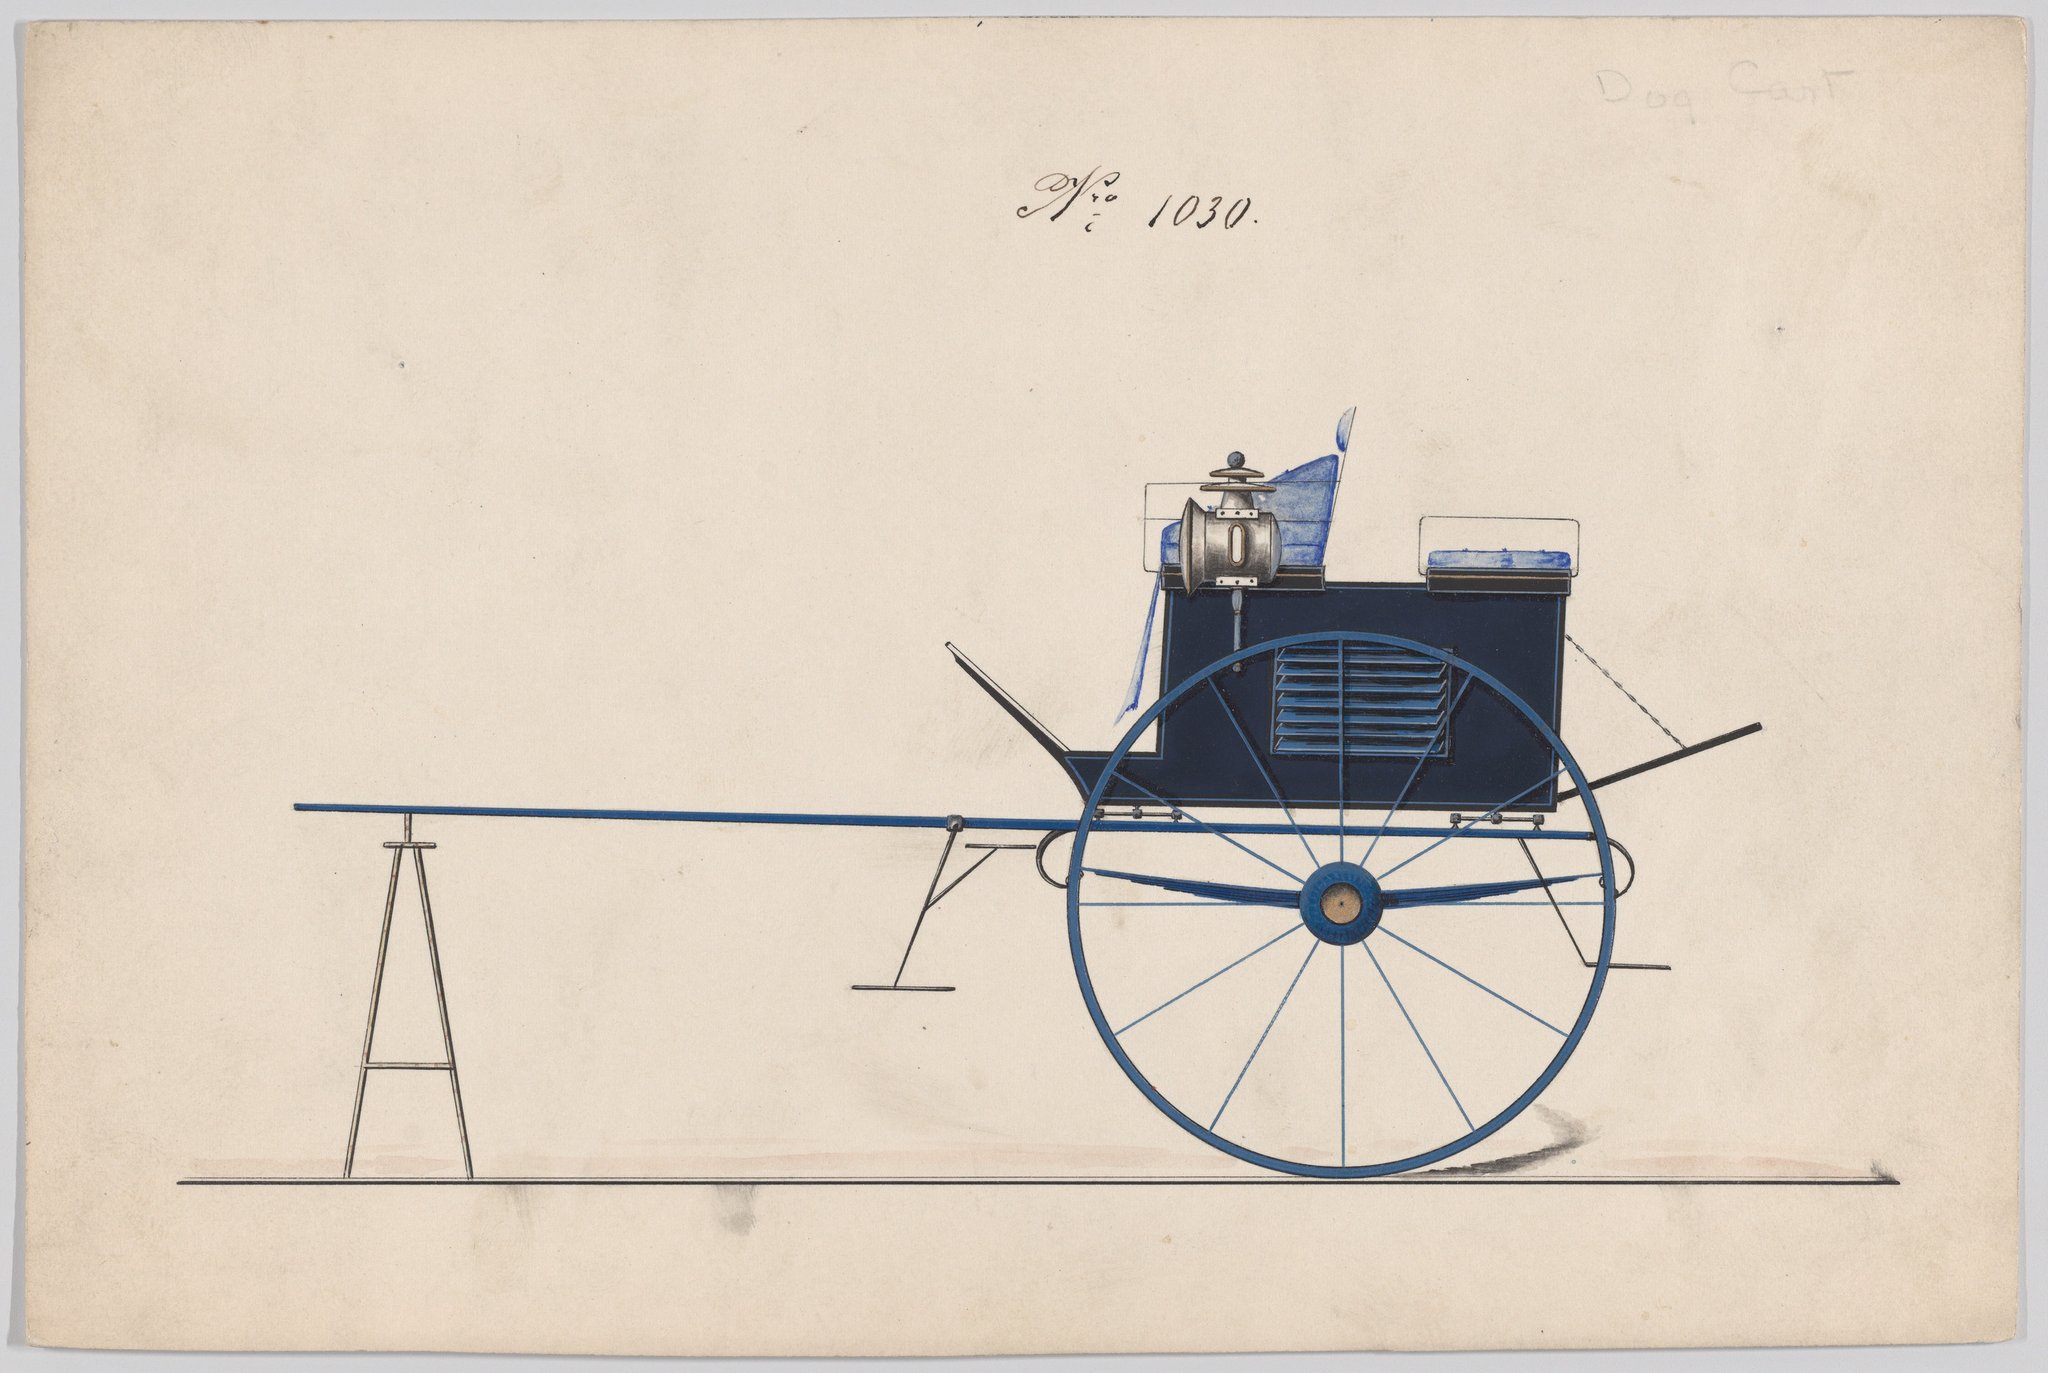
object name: drawing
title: Dog Cart #1030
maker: brewster & co.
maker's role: manufacturer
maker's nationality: american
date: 1870-1874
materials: gouache, ink, watercolor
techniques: pen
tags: carriages